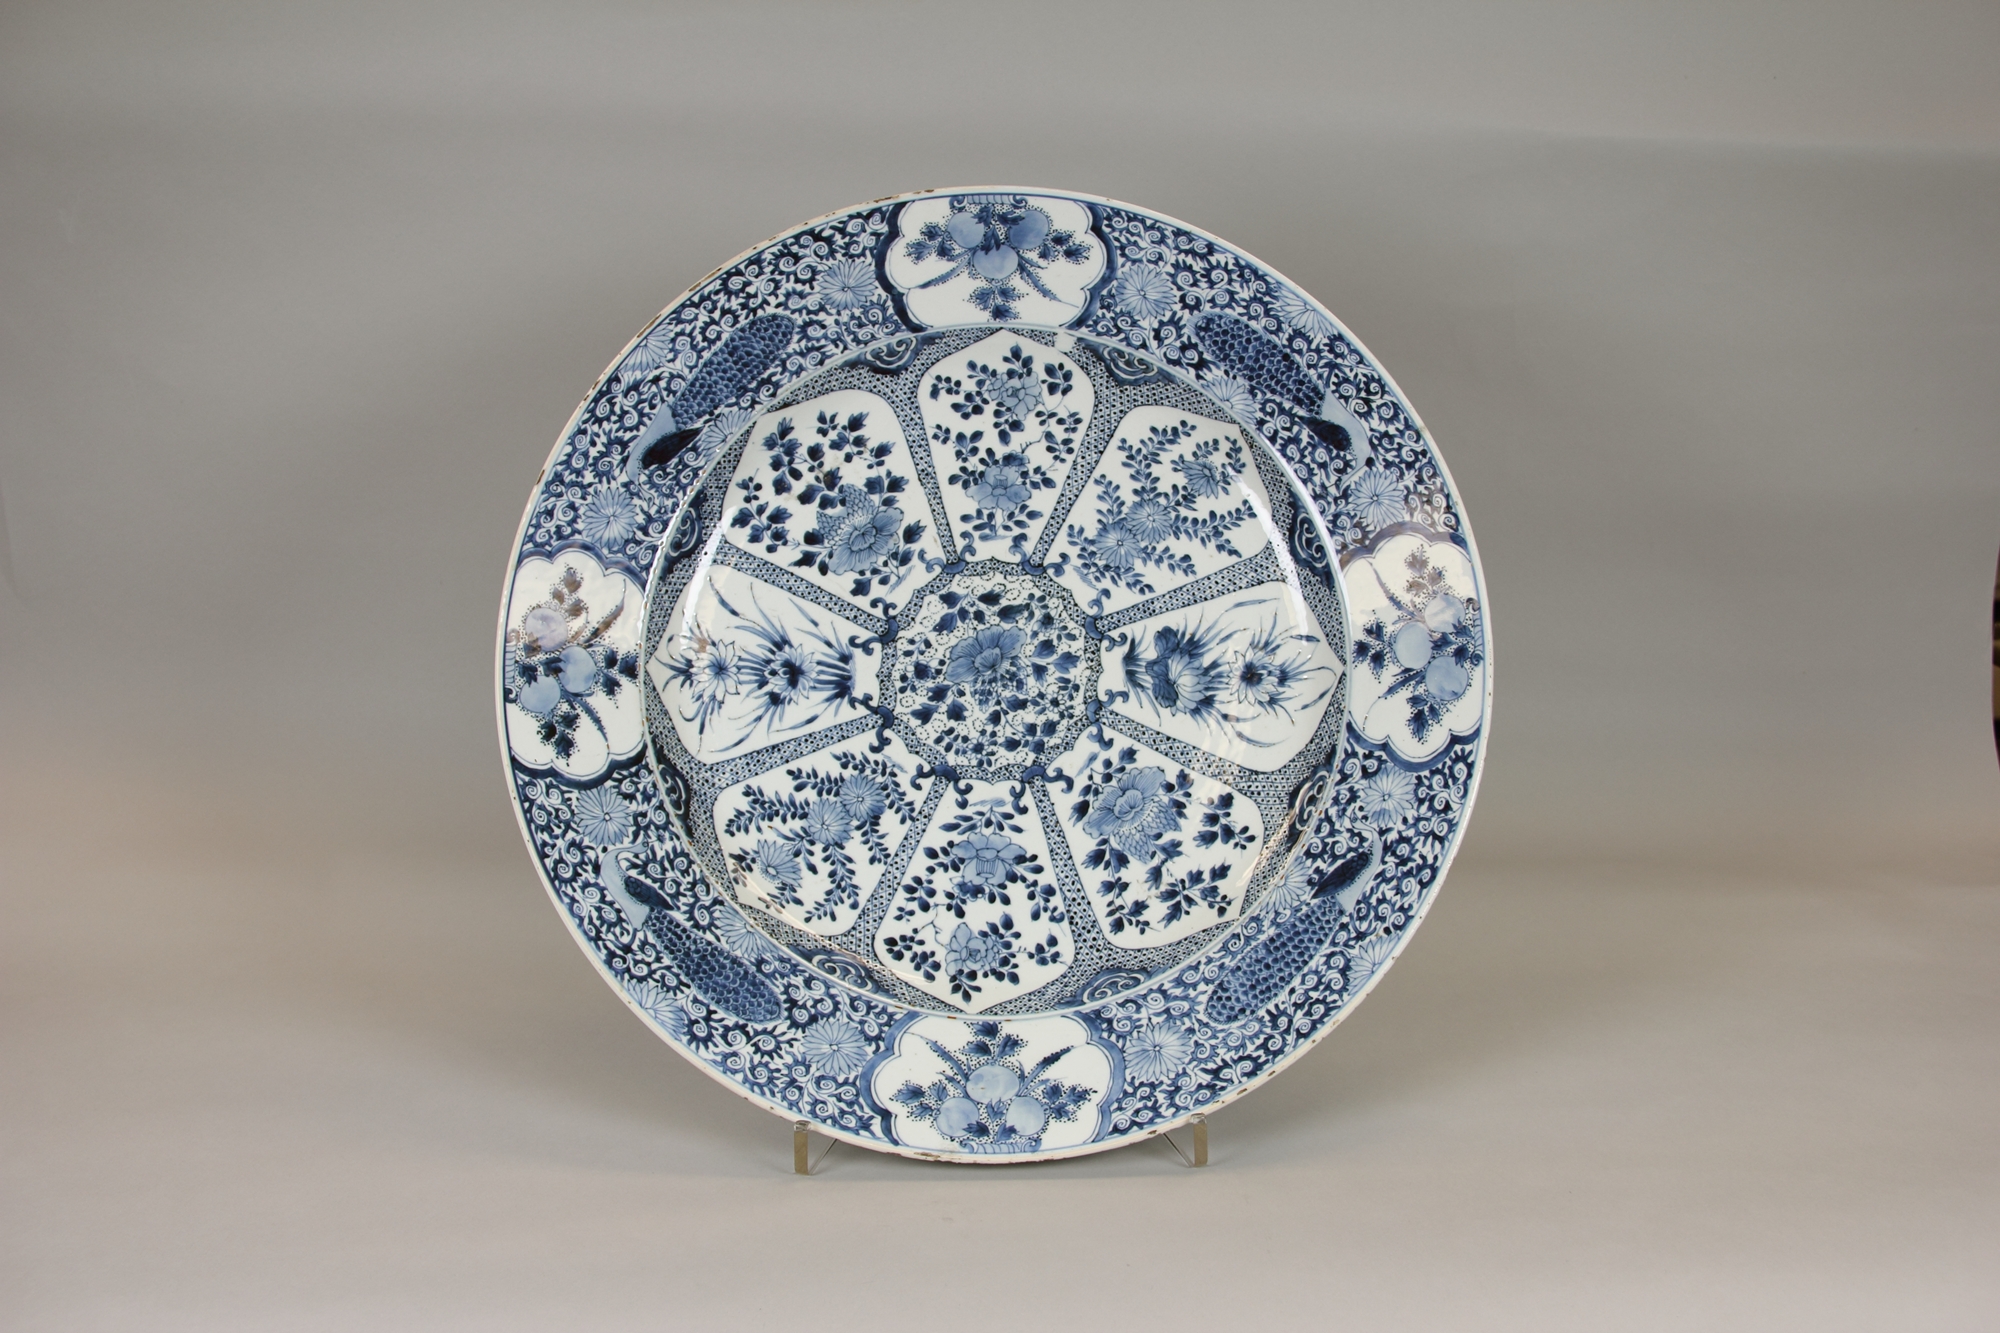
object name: plate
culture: chinese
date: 1667-1733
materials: porcelain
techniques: painting, underglaze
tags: flowers,leaves